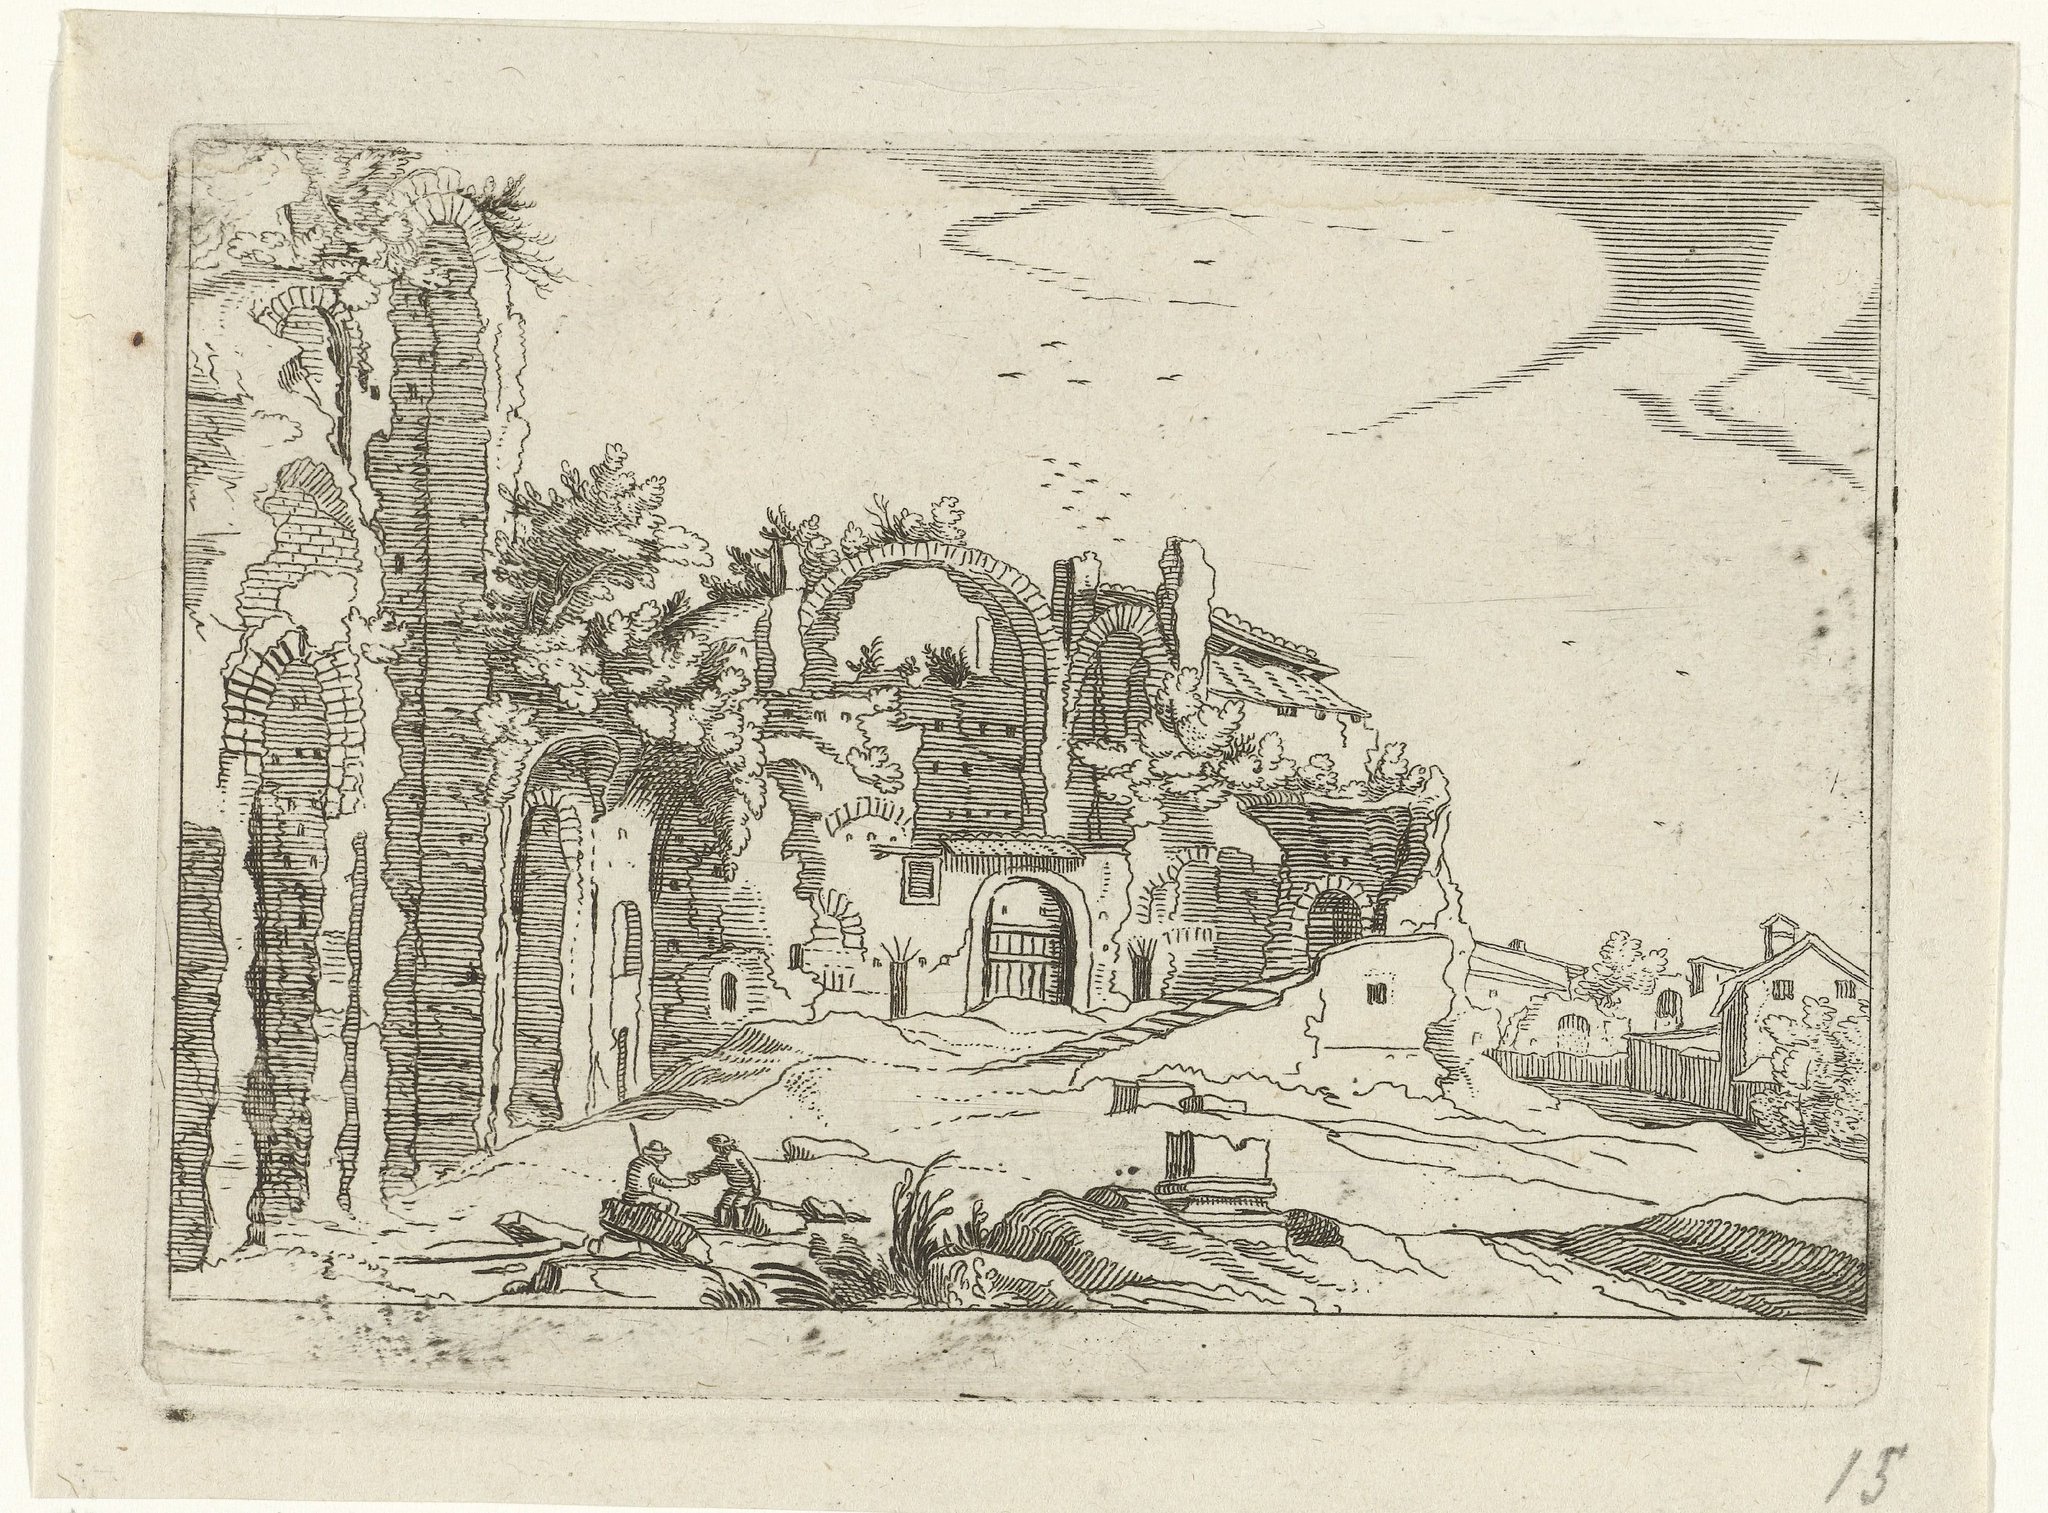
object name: print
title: Romeinse ruïnes (serie 2)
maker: Anonymous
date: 1594-1685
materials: paper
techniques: engraving, etching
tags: landscape with ruins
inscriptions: collector's mark: Lugt 2228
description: De ruïne van de thermen van Diocletianus in Rome. Rechts daarvan enkele huizen. Op de voorgrond zitten twee mannen op grote brokstukken. Prent uit een serie Romeinse ruïnes, bestaande uit kopieën naar een prentserie van Willem van Nieulandt.